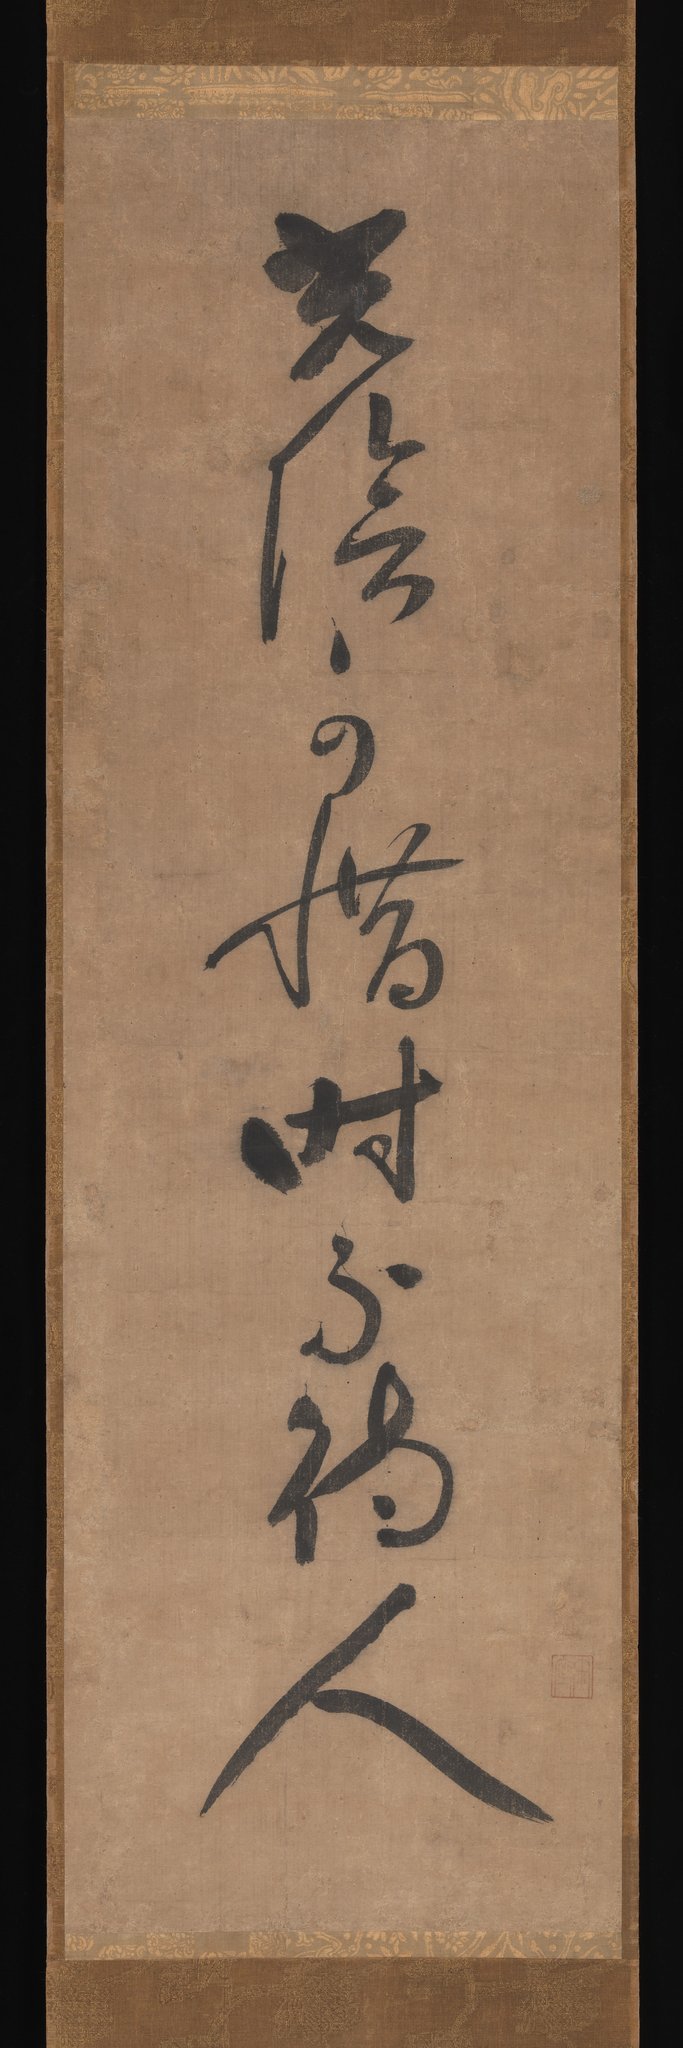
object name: hanging scroll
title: Zen Saying by Dahui Zonggao on the Passage of Time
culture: japanese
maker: jakushitsu genkō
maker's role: artist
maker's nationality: japanese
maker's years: 1290-1367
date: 1334-1366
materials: ink, paper